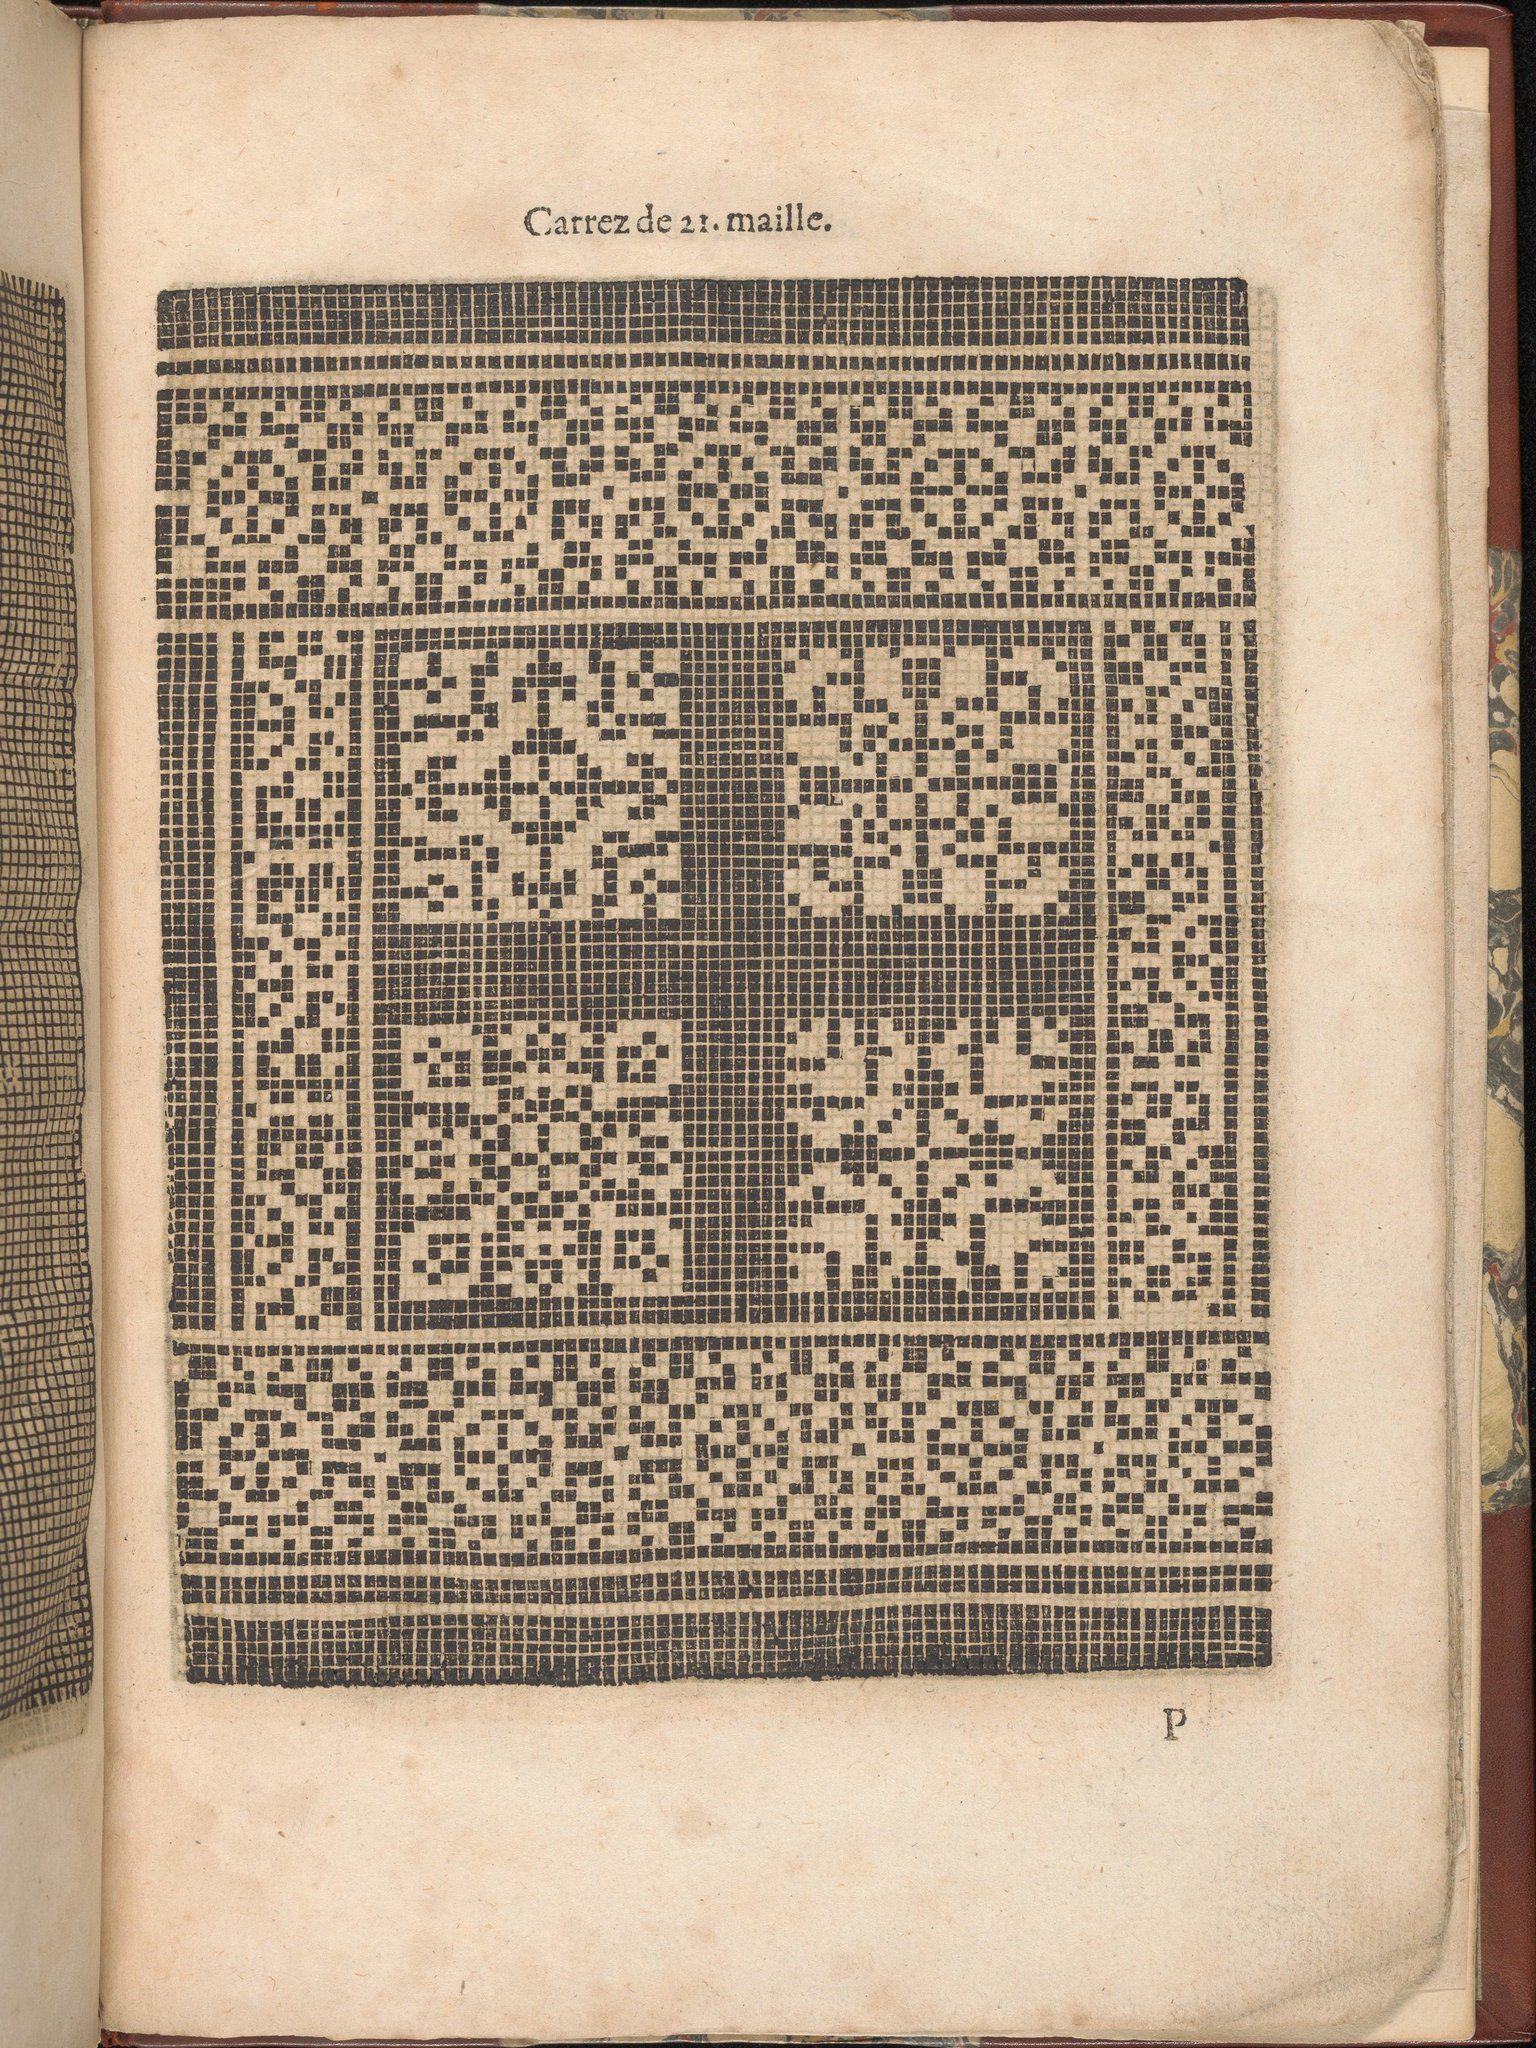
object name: book print ornament architecture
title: Les Secondes Oeuvres, et Subtiles Inventions De Lingerie du Seigneur Federic de Vinciolo Venitien, page 57 (recto)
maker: federico de vinciolo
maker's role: designer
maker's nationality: italian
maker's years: 1582-1599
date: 1603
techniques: woodcut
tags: ornament